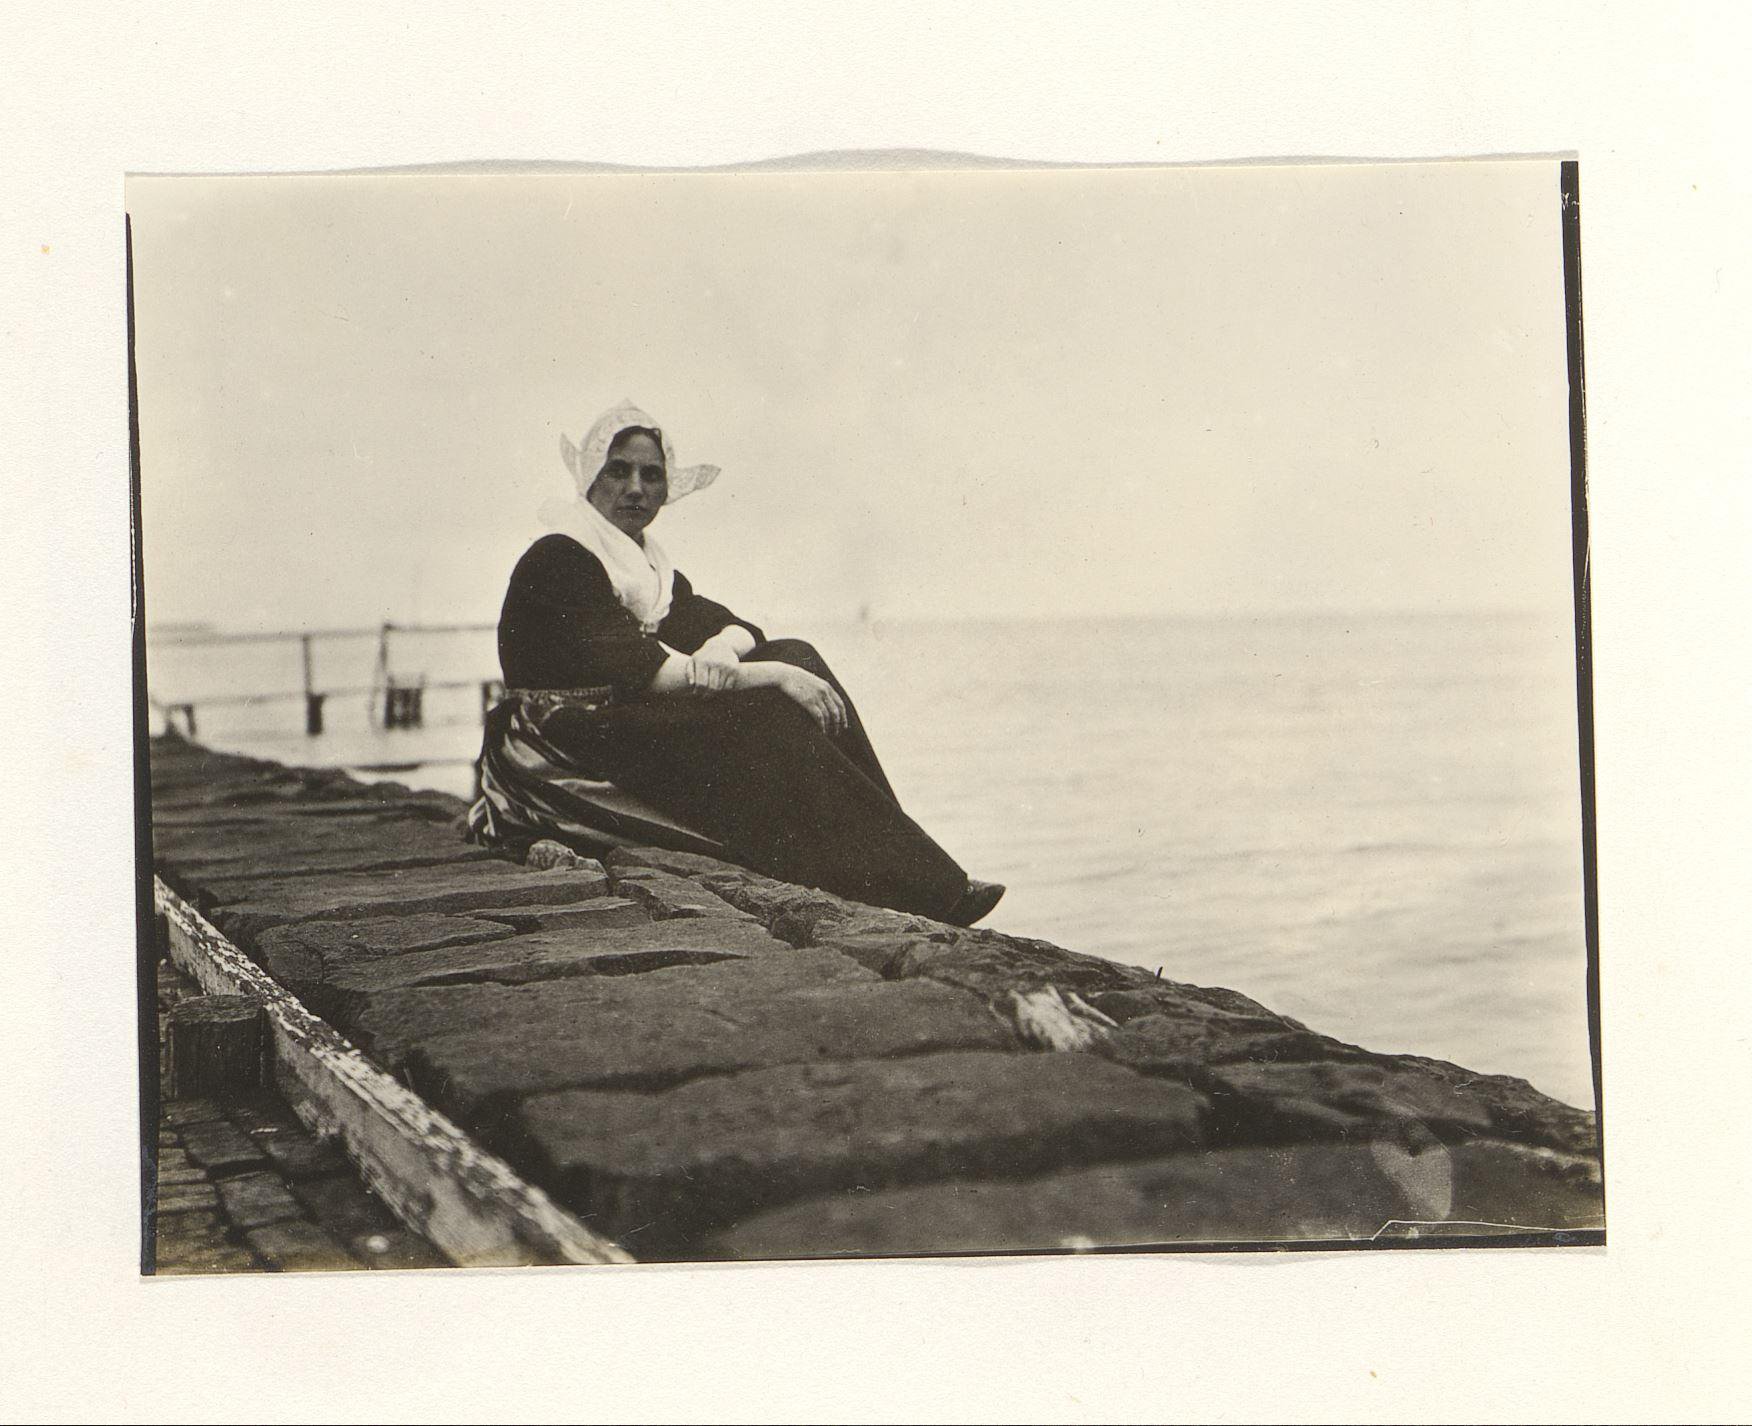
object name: album leaf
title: Vrouw in klederdracht aan een water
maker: george hidderley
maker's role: fotograaf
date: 1900-1910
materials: paper, photographic support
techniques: gelatin silver print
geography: volendam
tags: adult woman, historical persons, landscapes with waters, waterscapes, seascapes (in the temperate zone), folk costume, regional costume